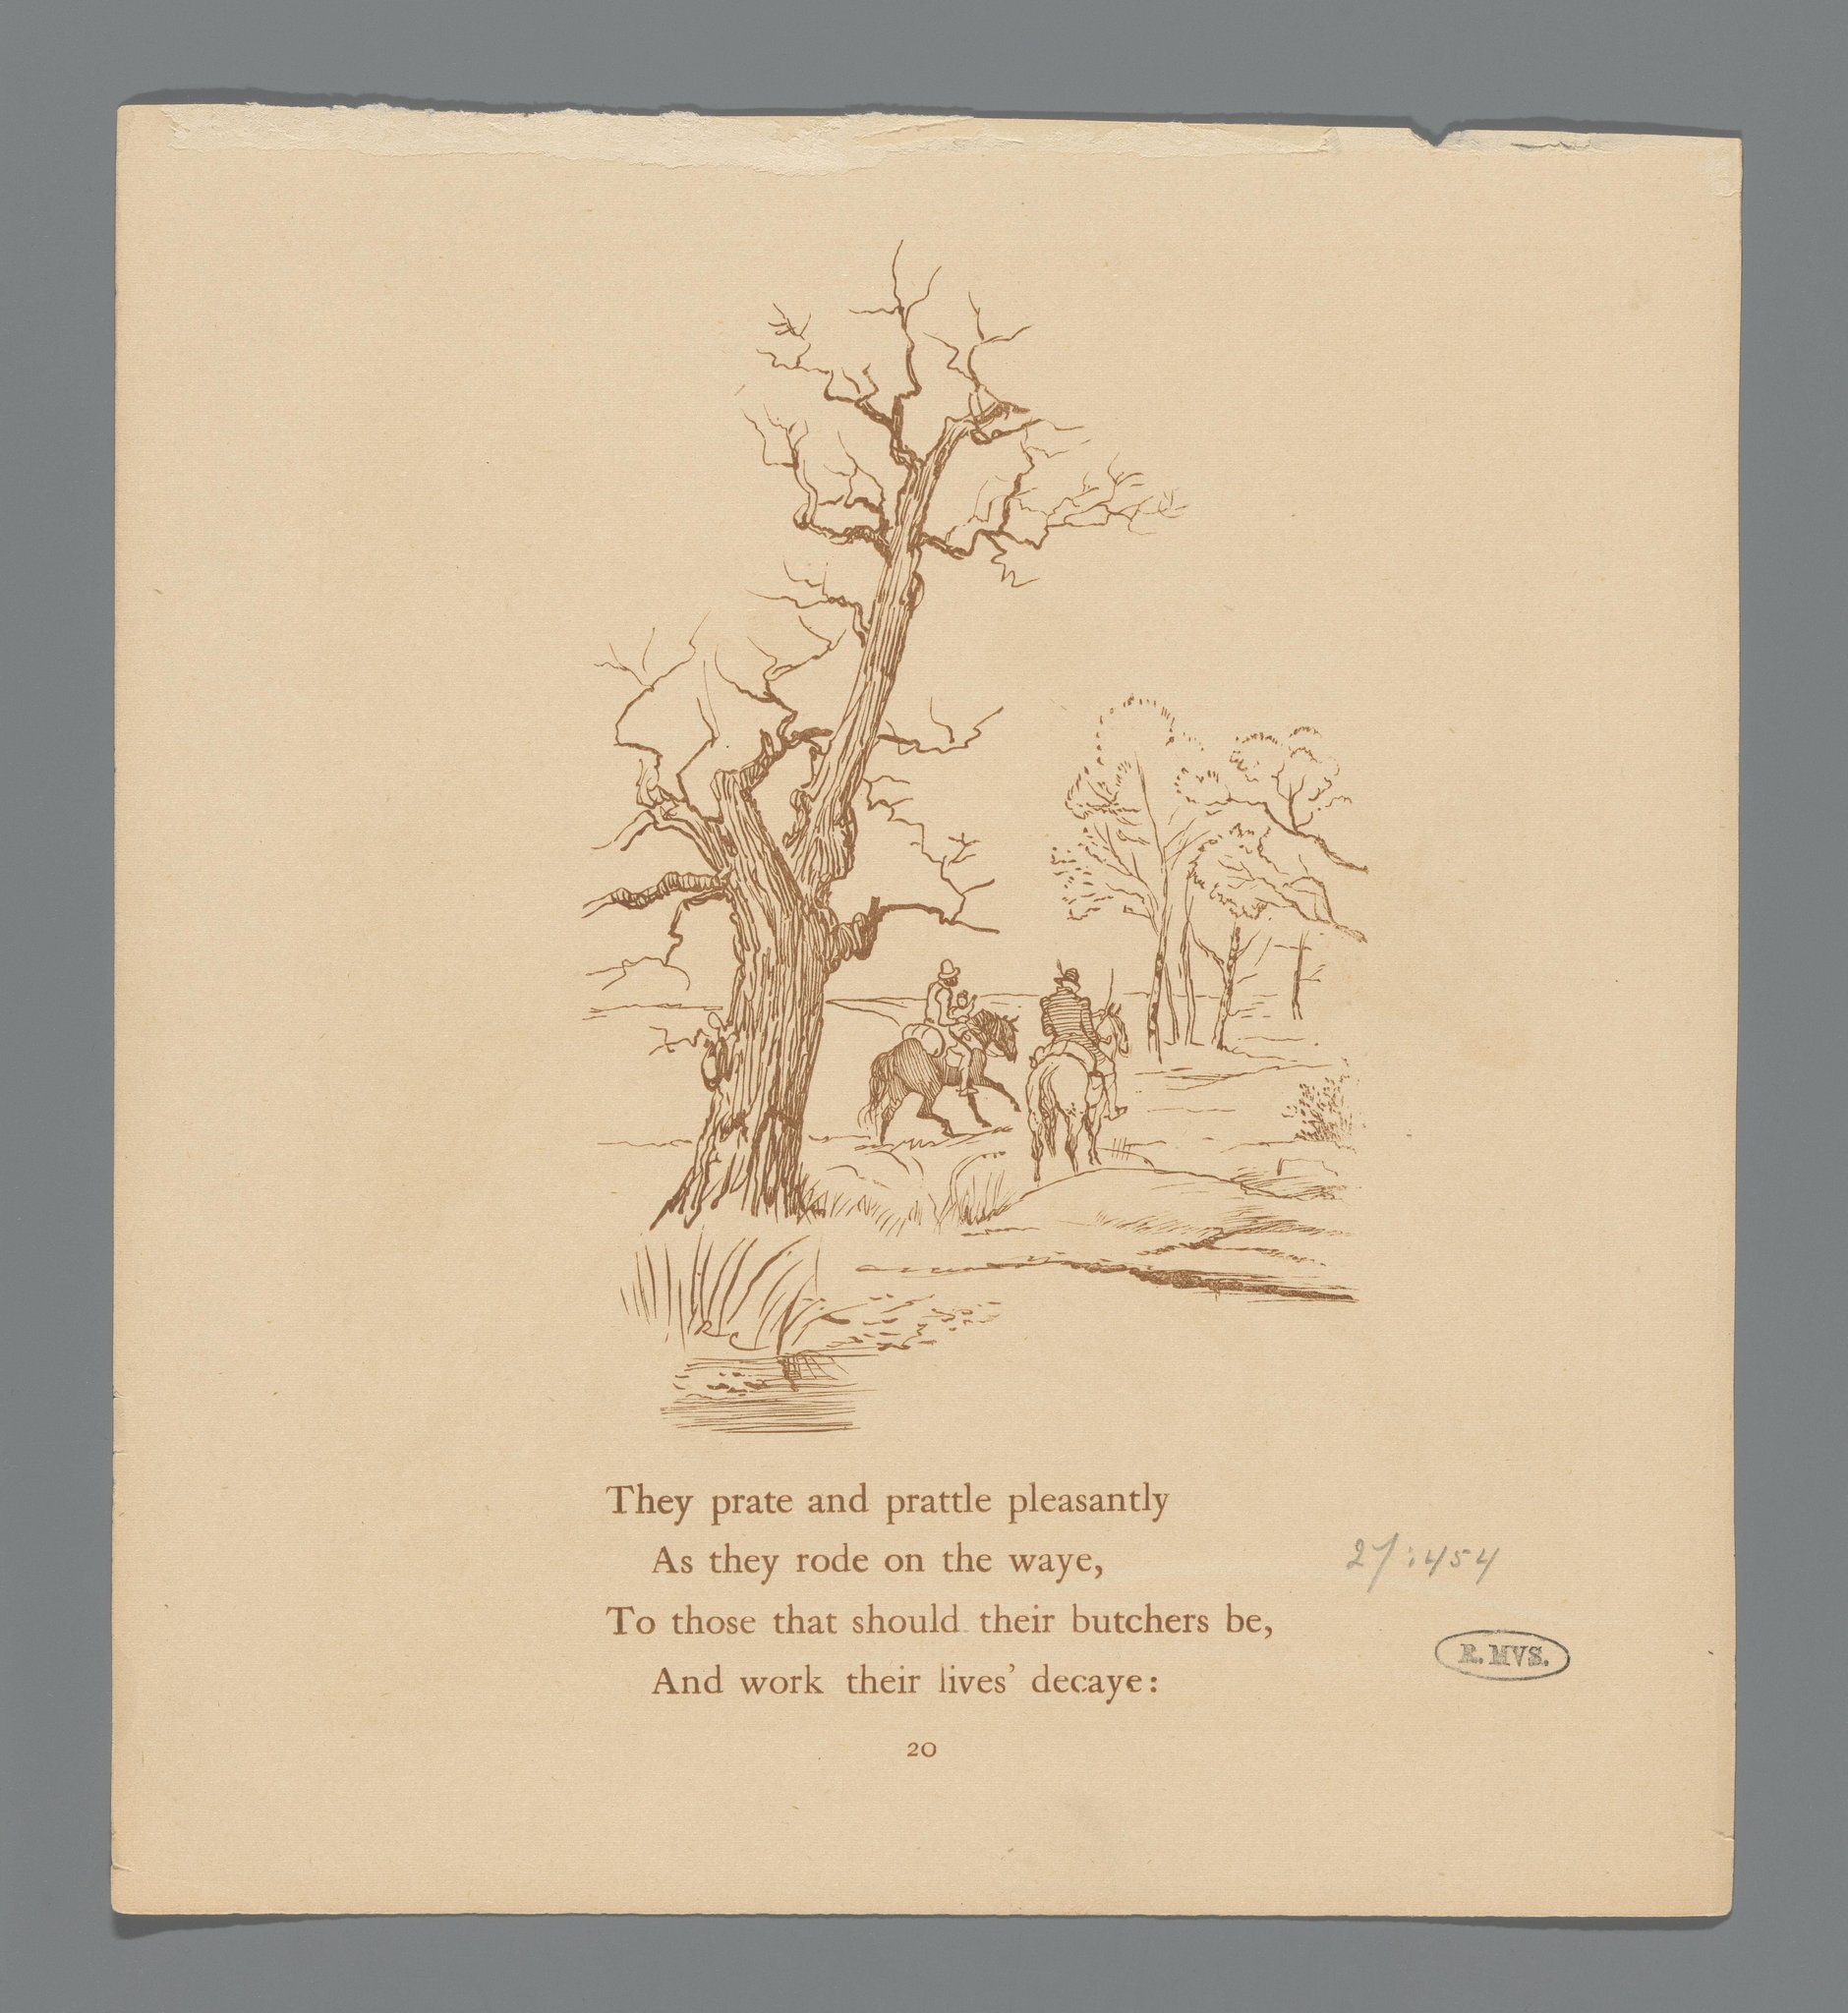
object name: book illustration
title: Landschap met twee ruiters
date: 1879-1927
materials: paper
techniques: letterpress printing, engraving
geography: london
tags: riding a horse, ass, or mule; rider, horseman, landscapes in the temperate zone (+ landscape with figures, staffage)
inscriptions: collector's mark: Lugt 2228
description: Prent uit: The babes in the wood. Londen: George Routledge & Sons, 1879. Of uit een later gepubliceerde (gebundelde) uitgave.